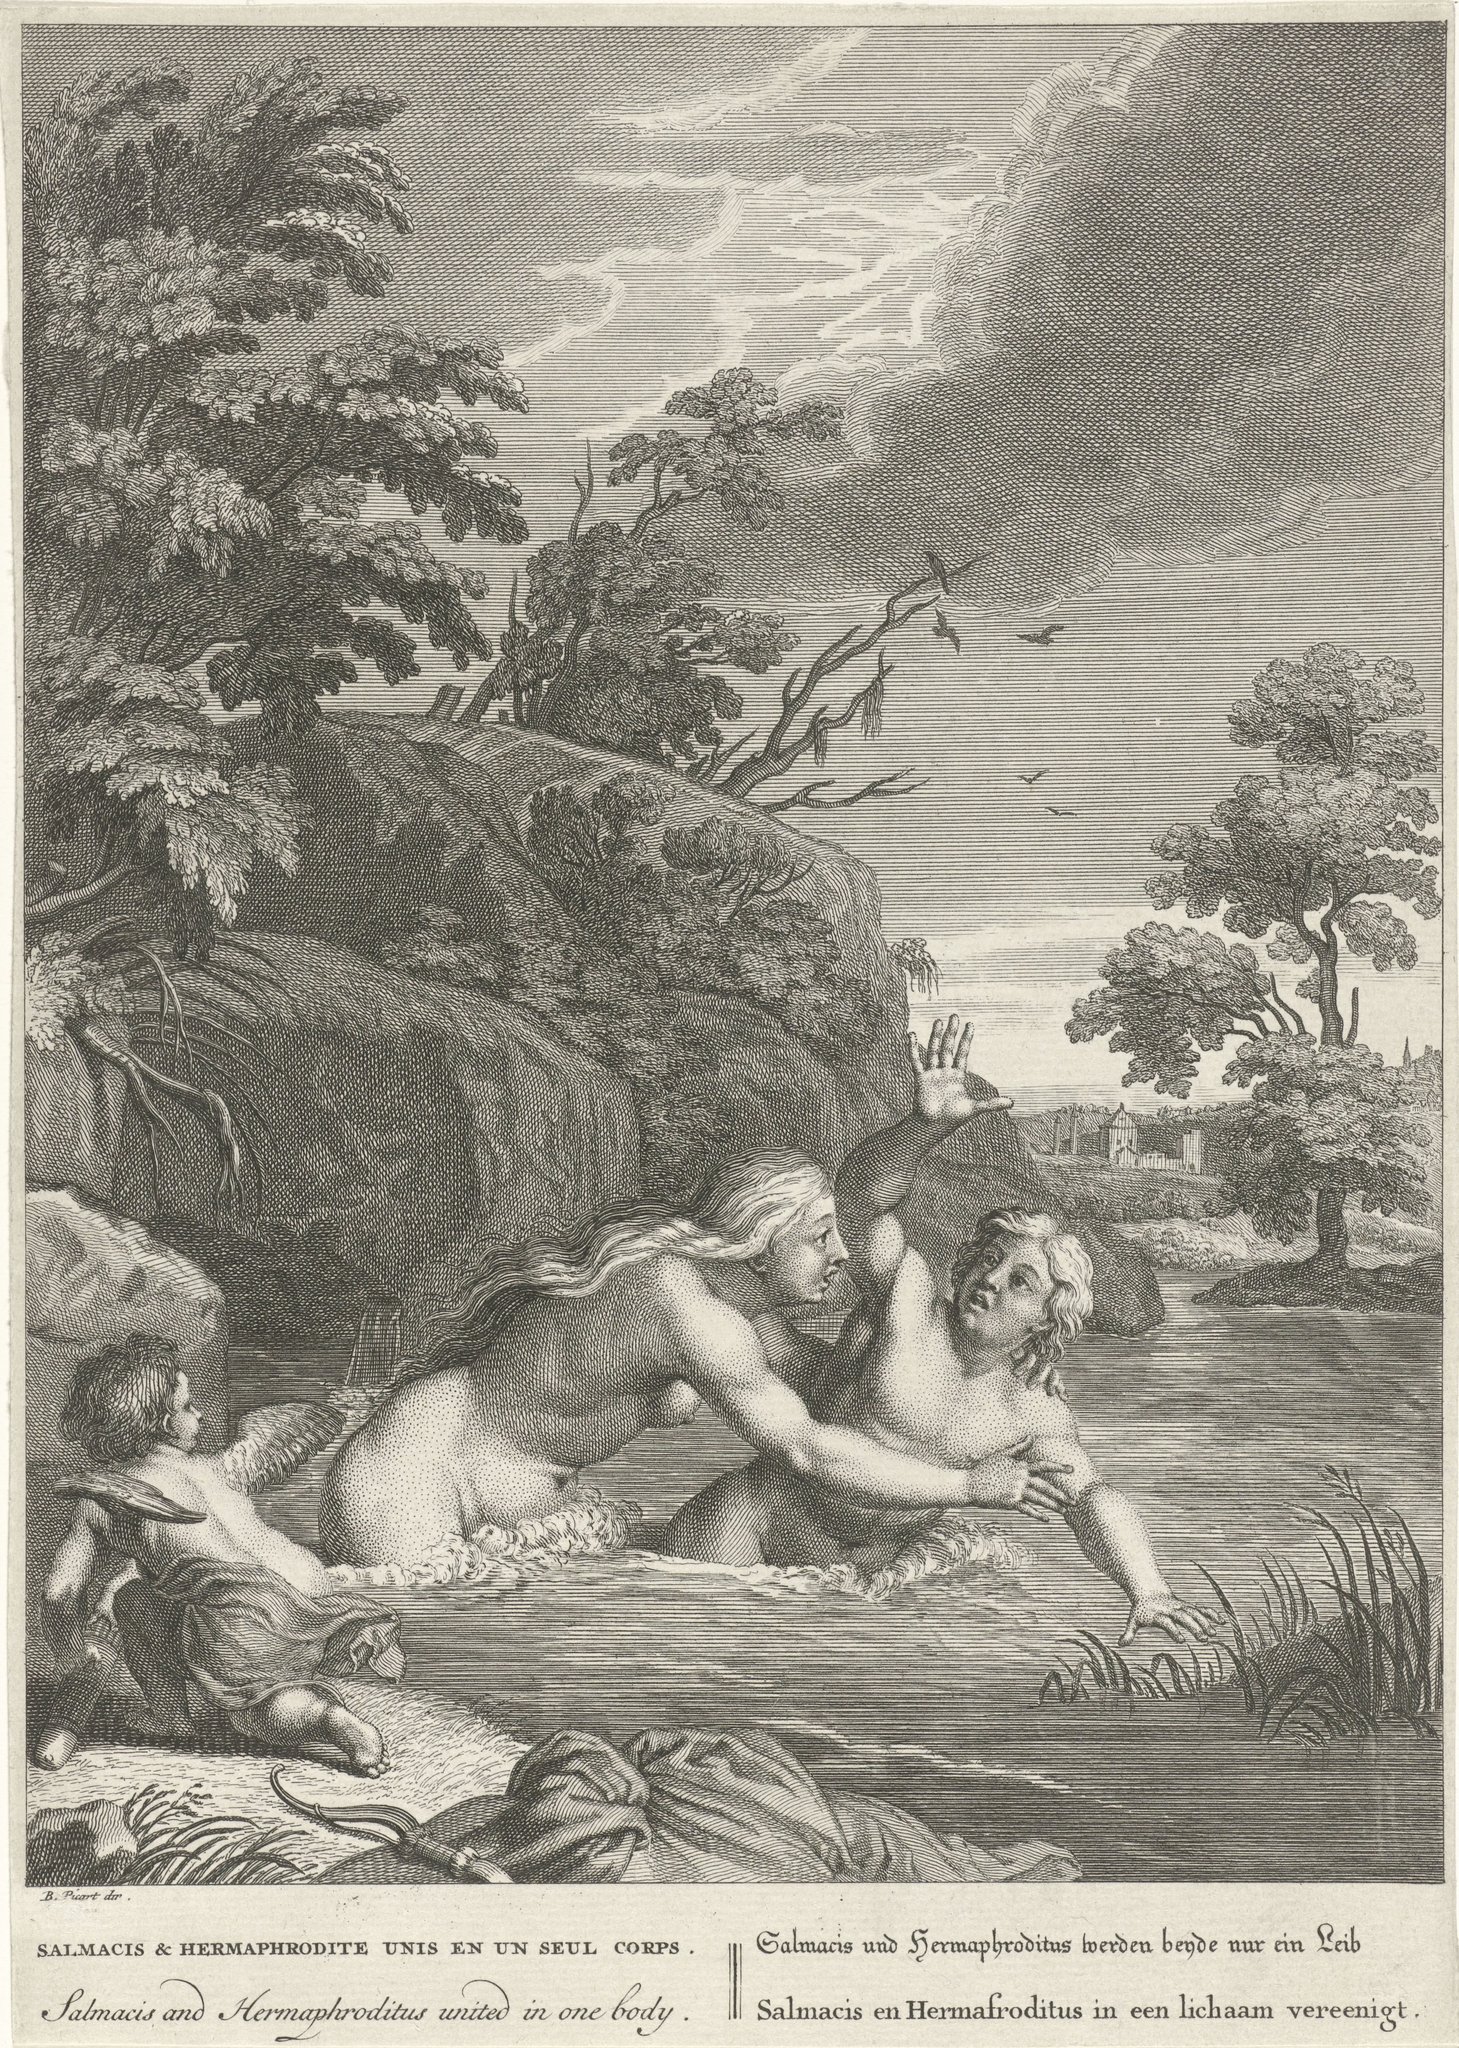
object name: print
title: Salmacis en Hermaphroditus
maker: bernard picart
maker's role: draughtsman, print maker, publisher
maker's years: 1673-1733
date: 1733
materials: paper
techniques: engraving, etching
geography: amsterdam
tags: story of hermaphroditus and salmacis, hermaphroditus and salmacis changed into a hermaphrodite: at the prayer of the fountain-nymph salmacis, who holds the bathing hermaphroditus closely embraced, their bodies fuse (ovid, metamorphoses iv 373)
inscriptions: collector's mark: Lugt 2228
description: Landschap met Salmacis en Hermaphroditus in het meer waarin Salmacis woonde. Salmacis, een van Diana's nimfen, werd verliefd op Hermaphroditus. Zij reikt naar hem, terwijl hij haar probeert af te weren, voordat zij hem zou omhelzen en ze volgens de mythe zouden versmelten tot een tweeslachtig wezen. Amor kijkt toe vanaf de oever. In de marge de titel in het Frans, Engels, Duits en Nederlands.